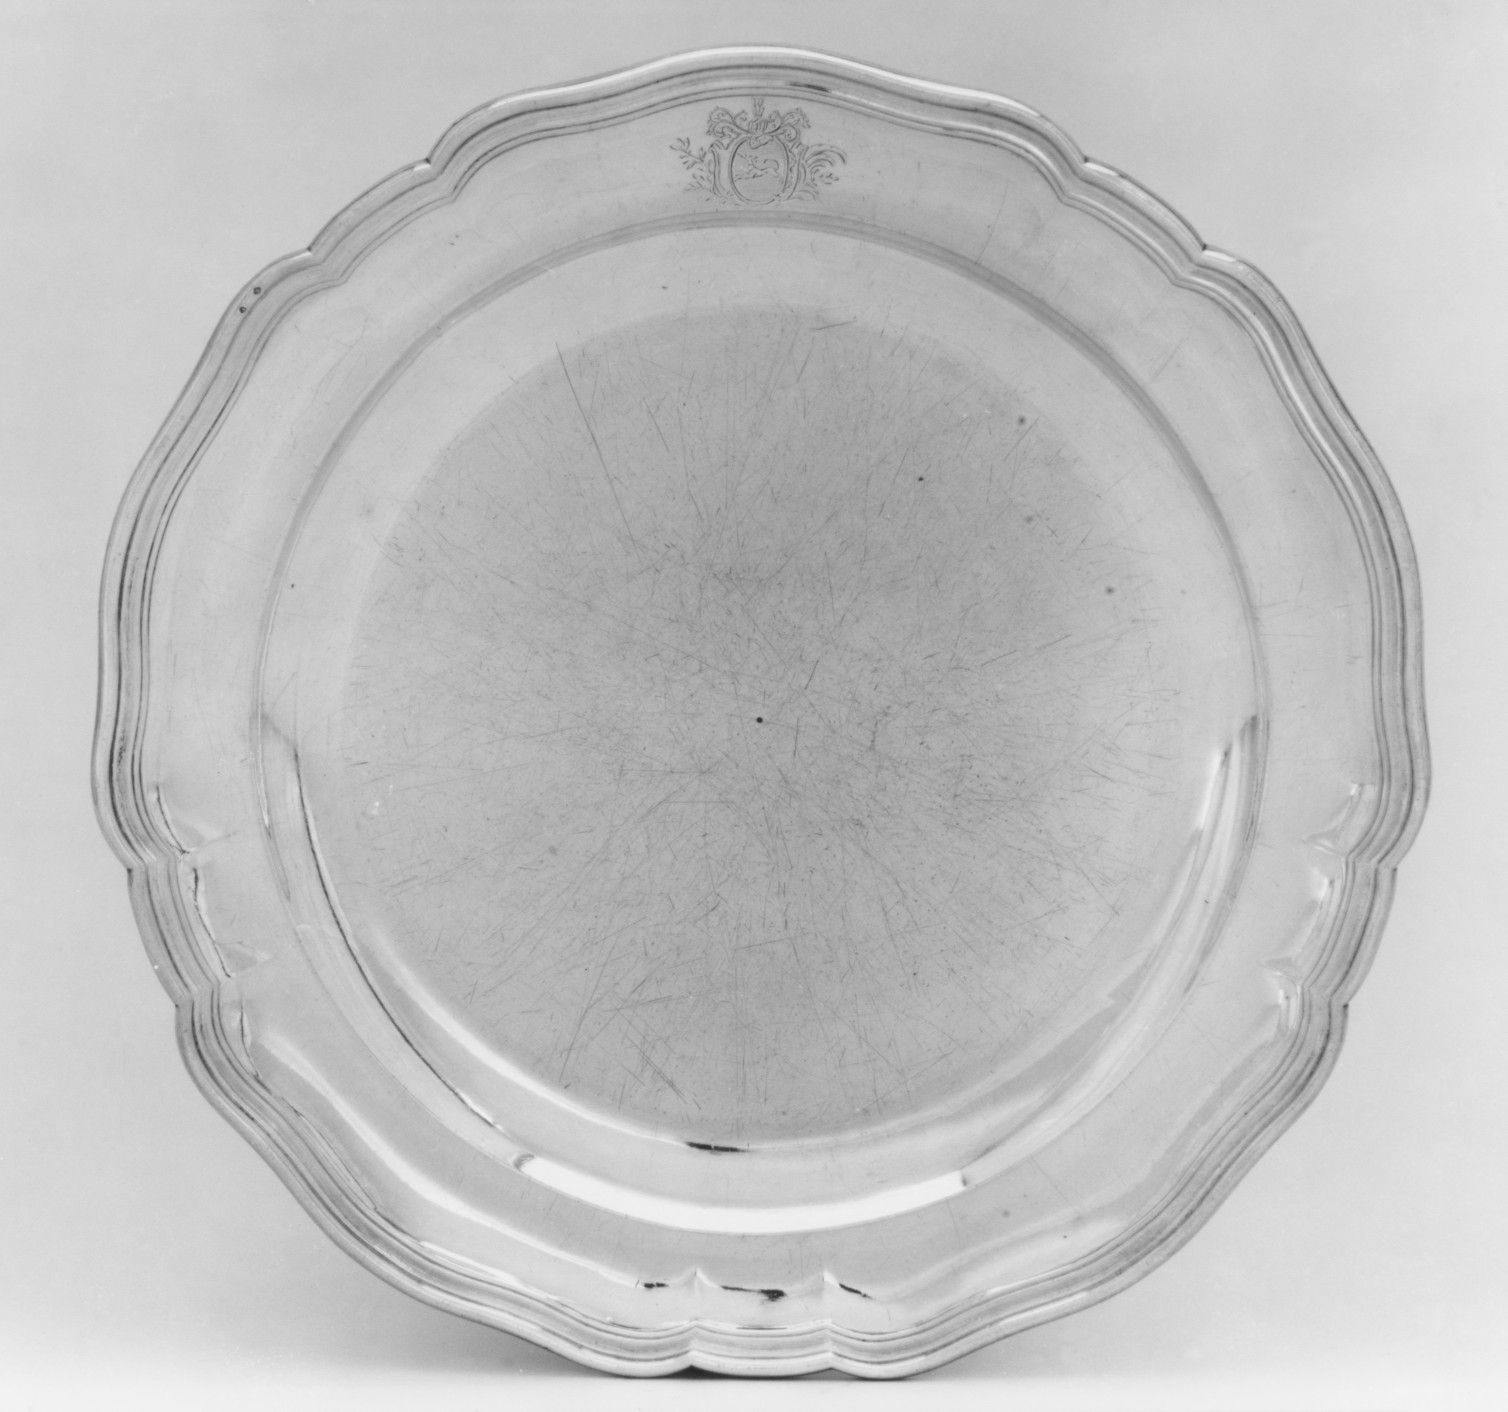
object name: plate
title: Plate (one of a set of two of graduated size)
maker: edme-pierre balzac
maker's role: maker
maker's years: 1705-1786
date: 1771-1772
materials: silver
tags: coat of arms